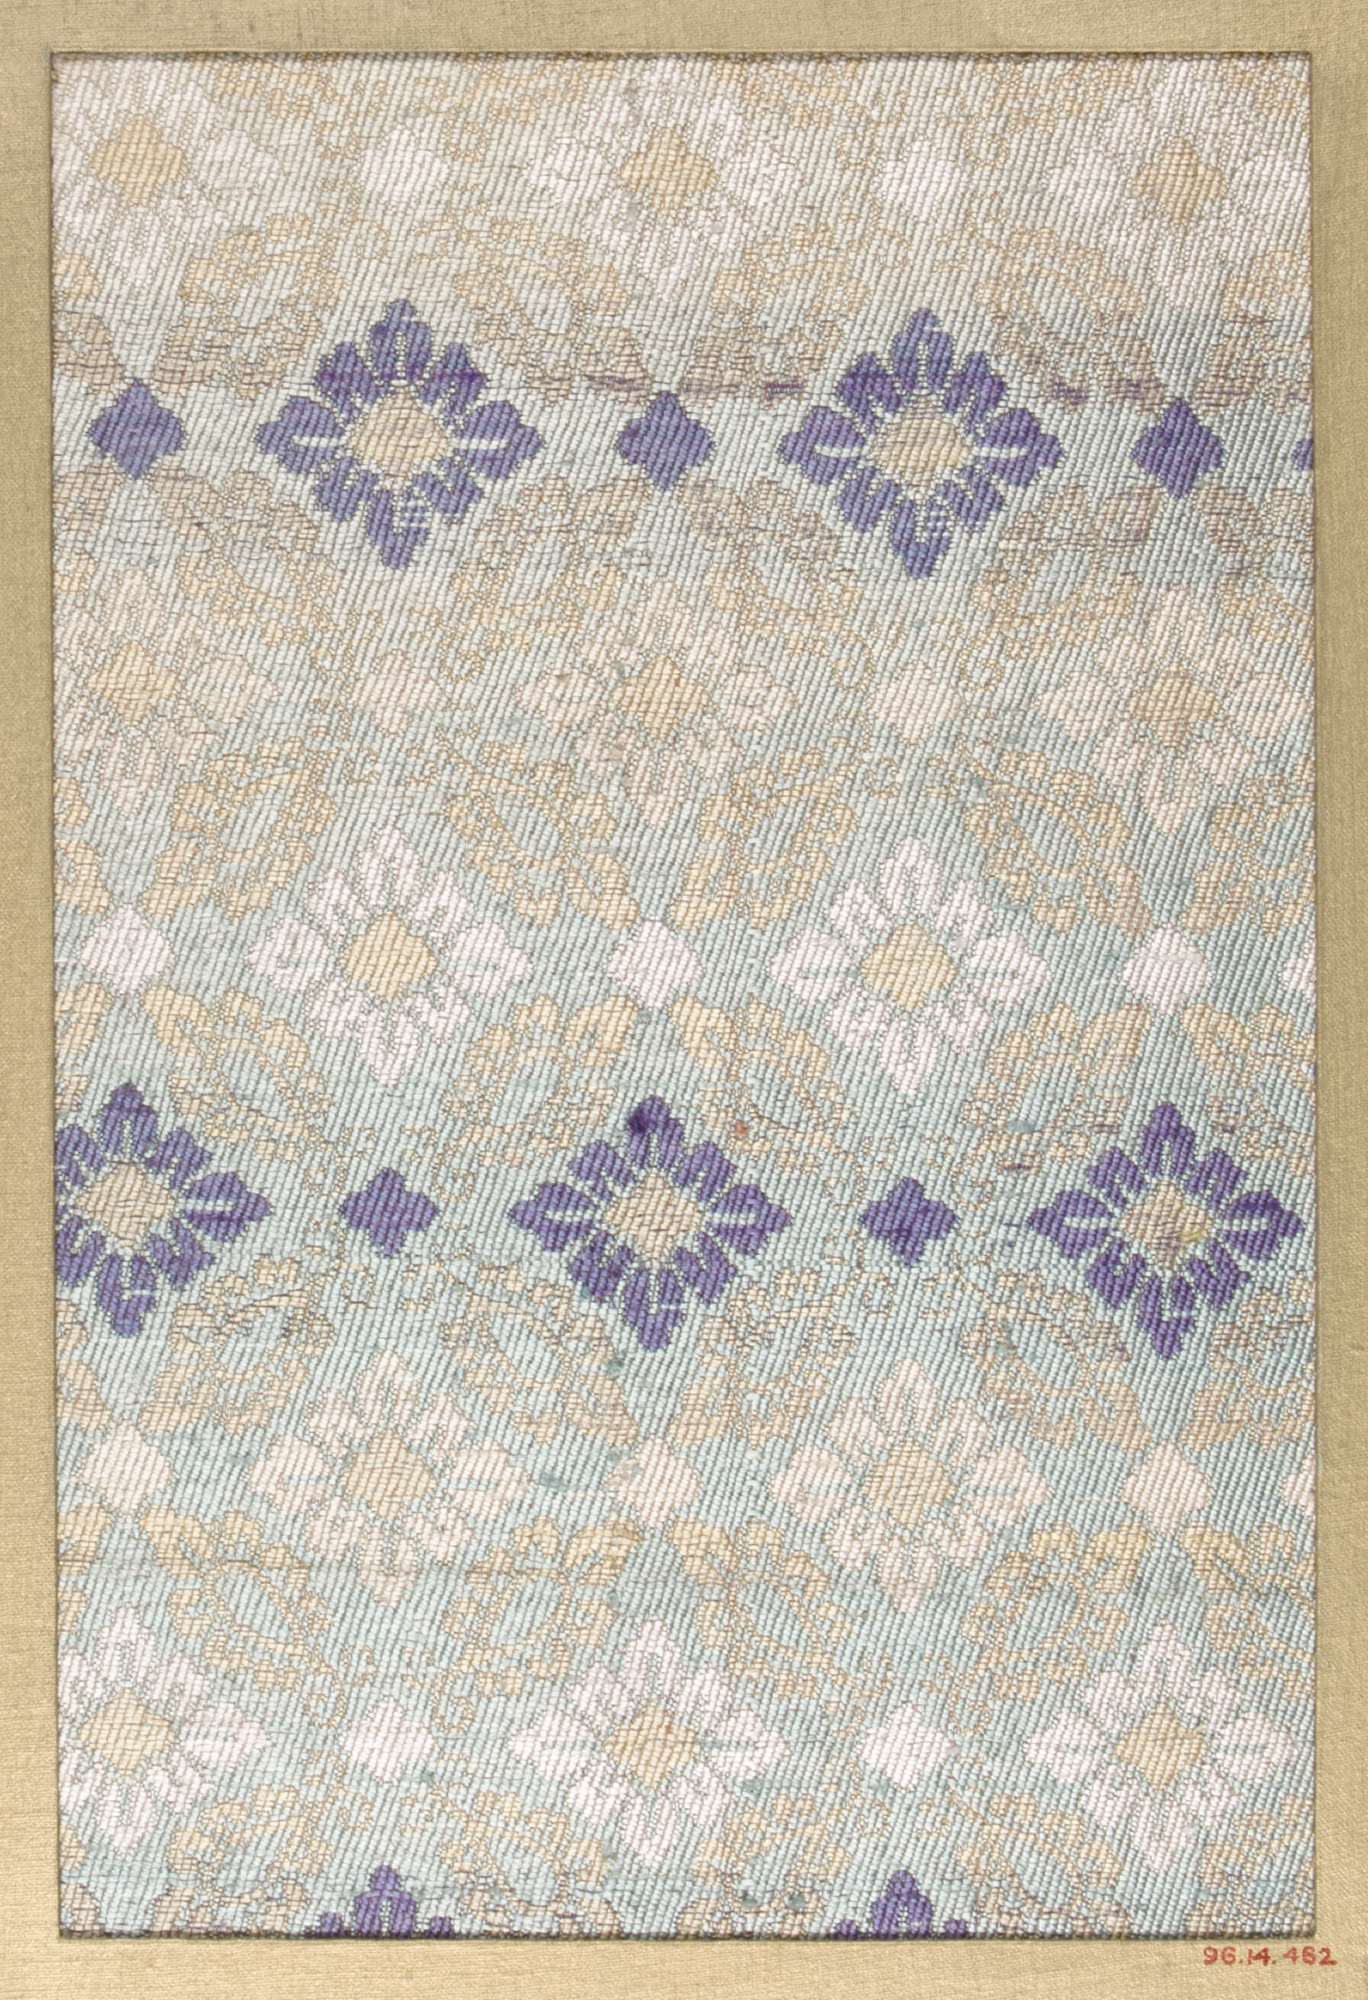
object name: piece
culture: japanese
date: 1701-1900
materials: silk